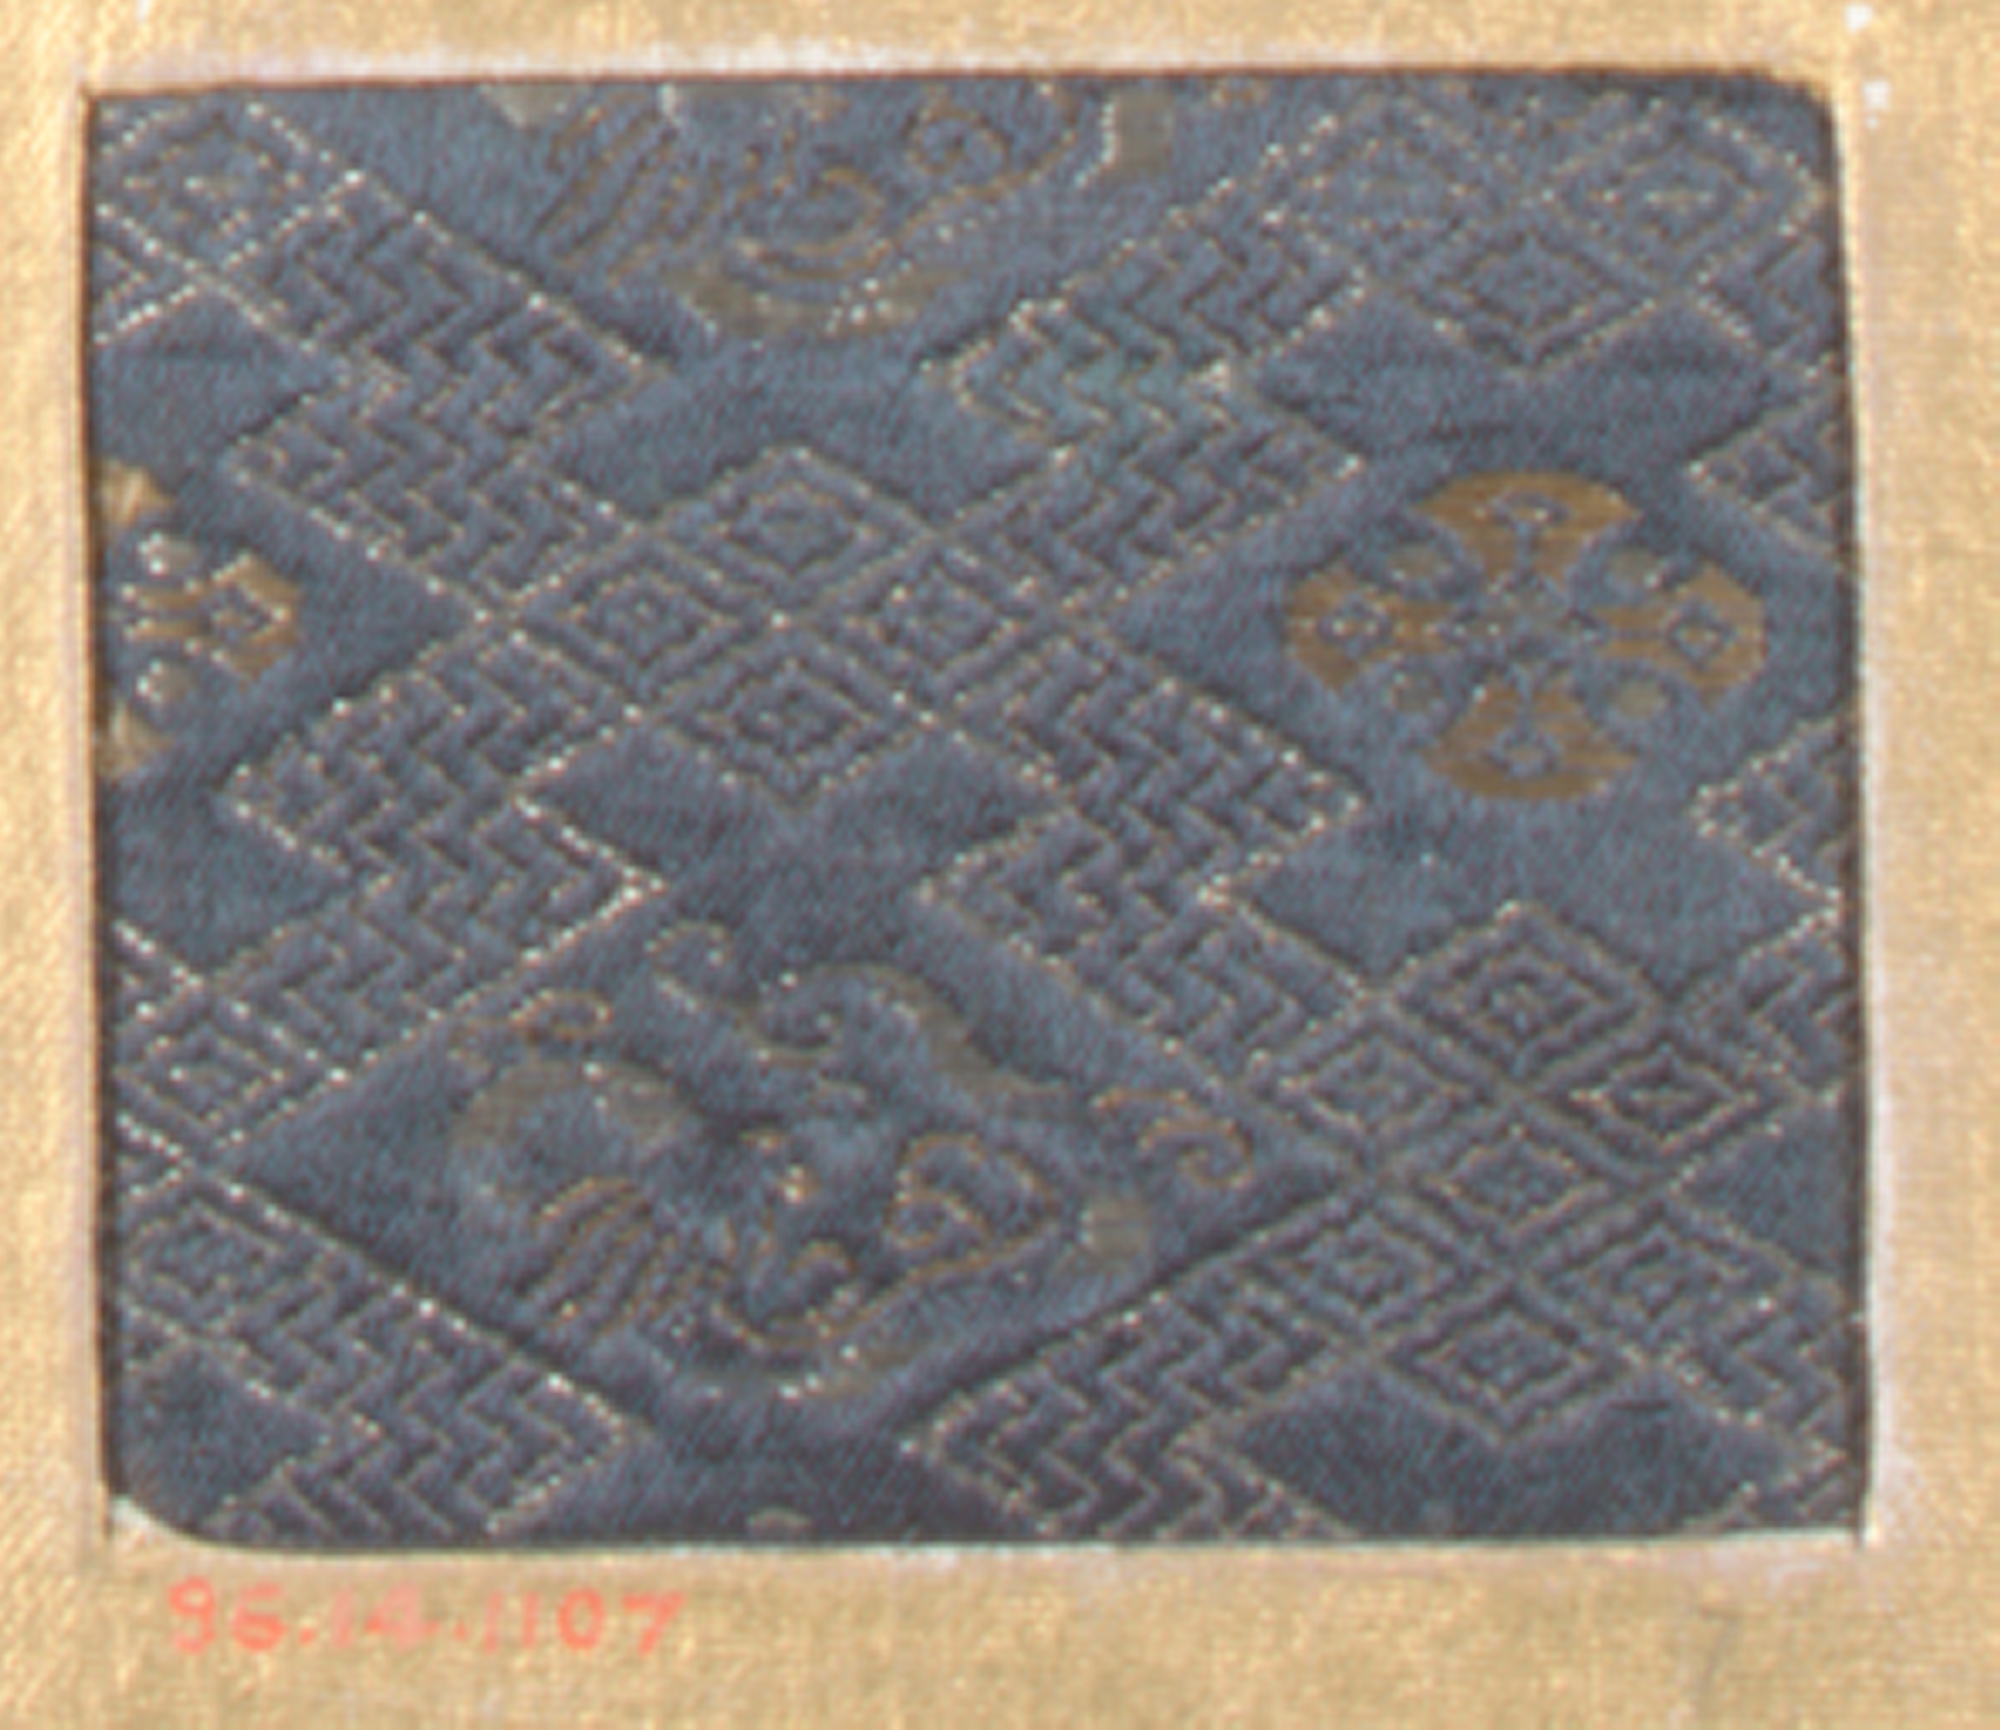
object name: piece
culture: japanese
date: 1701-1900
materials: silk